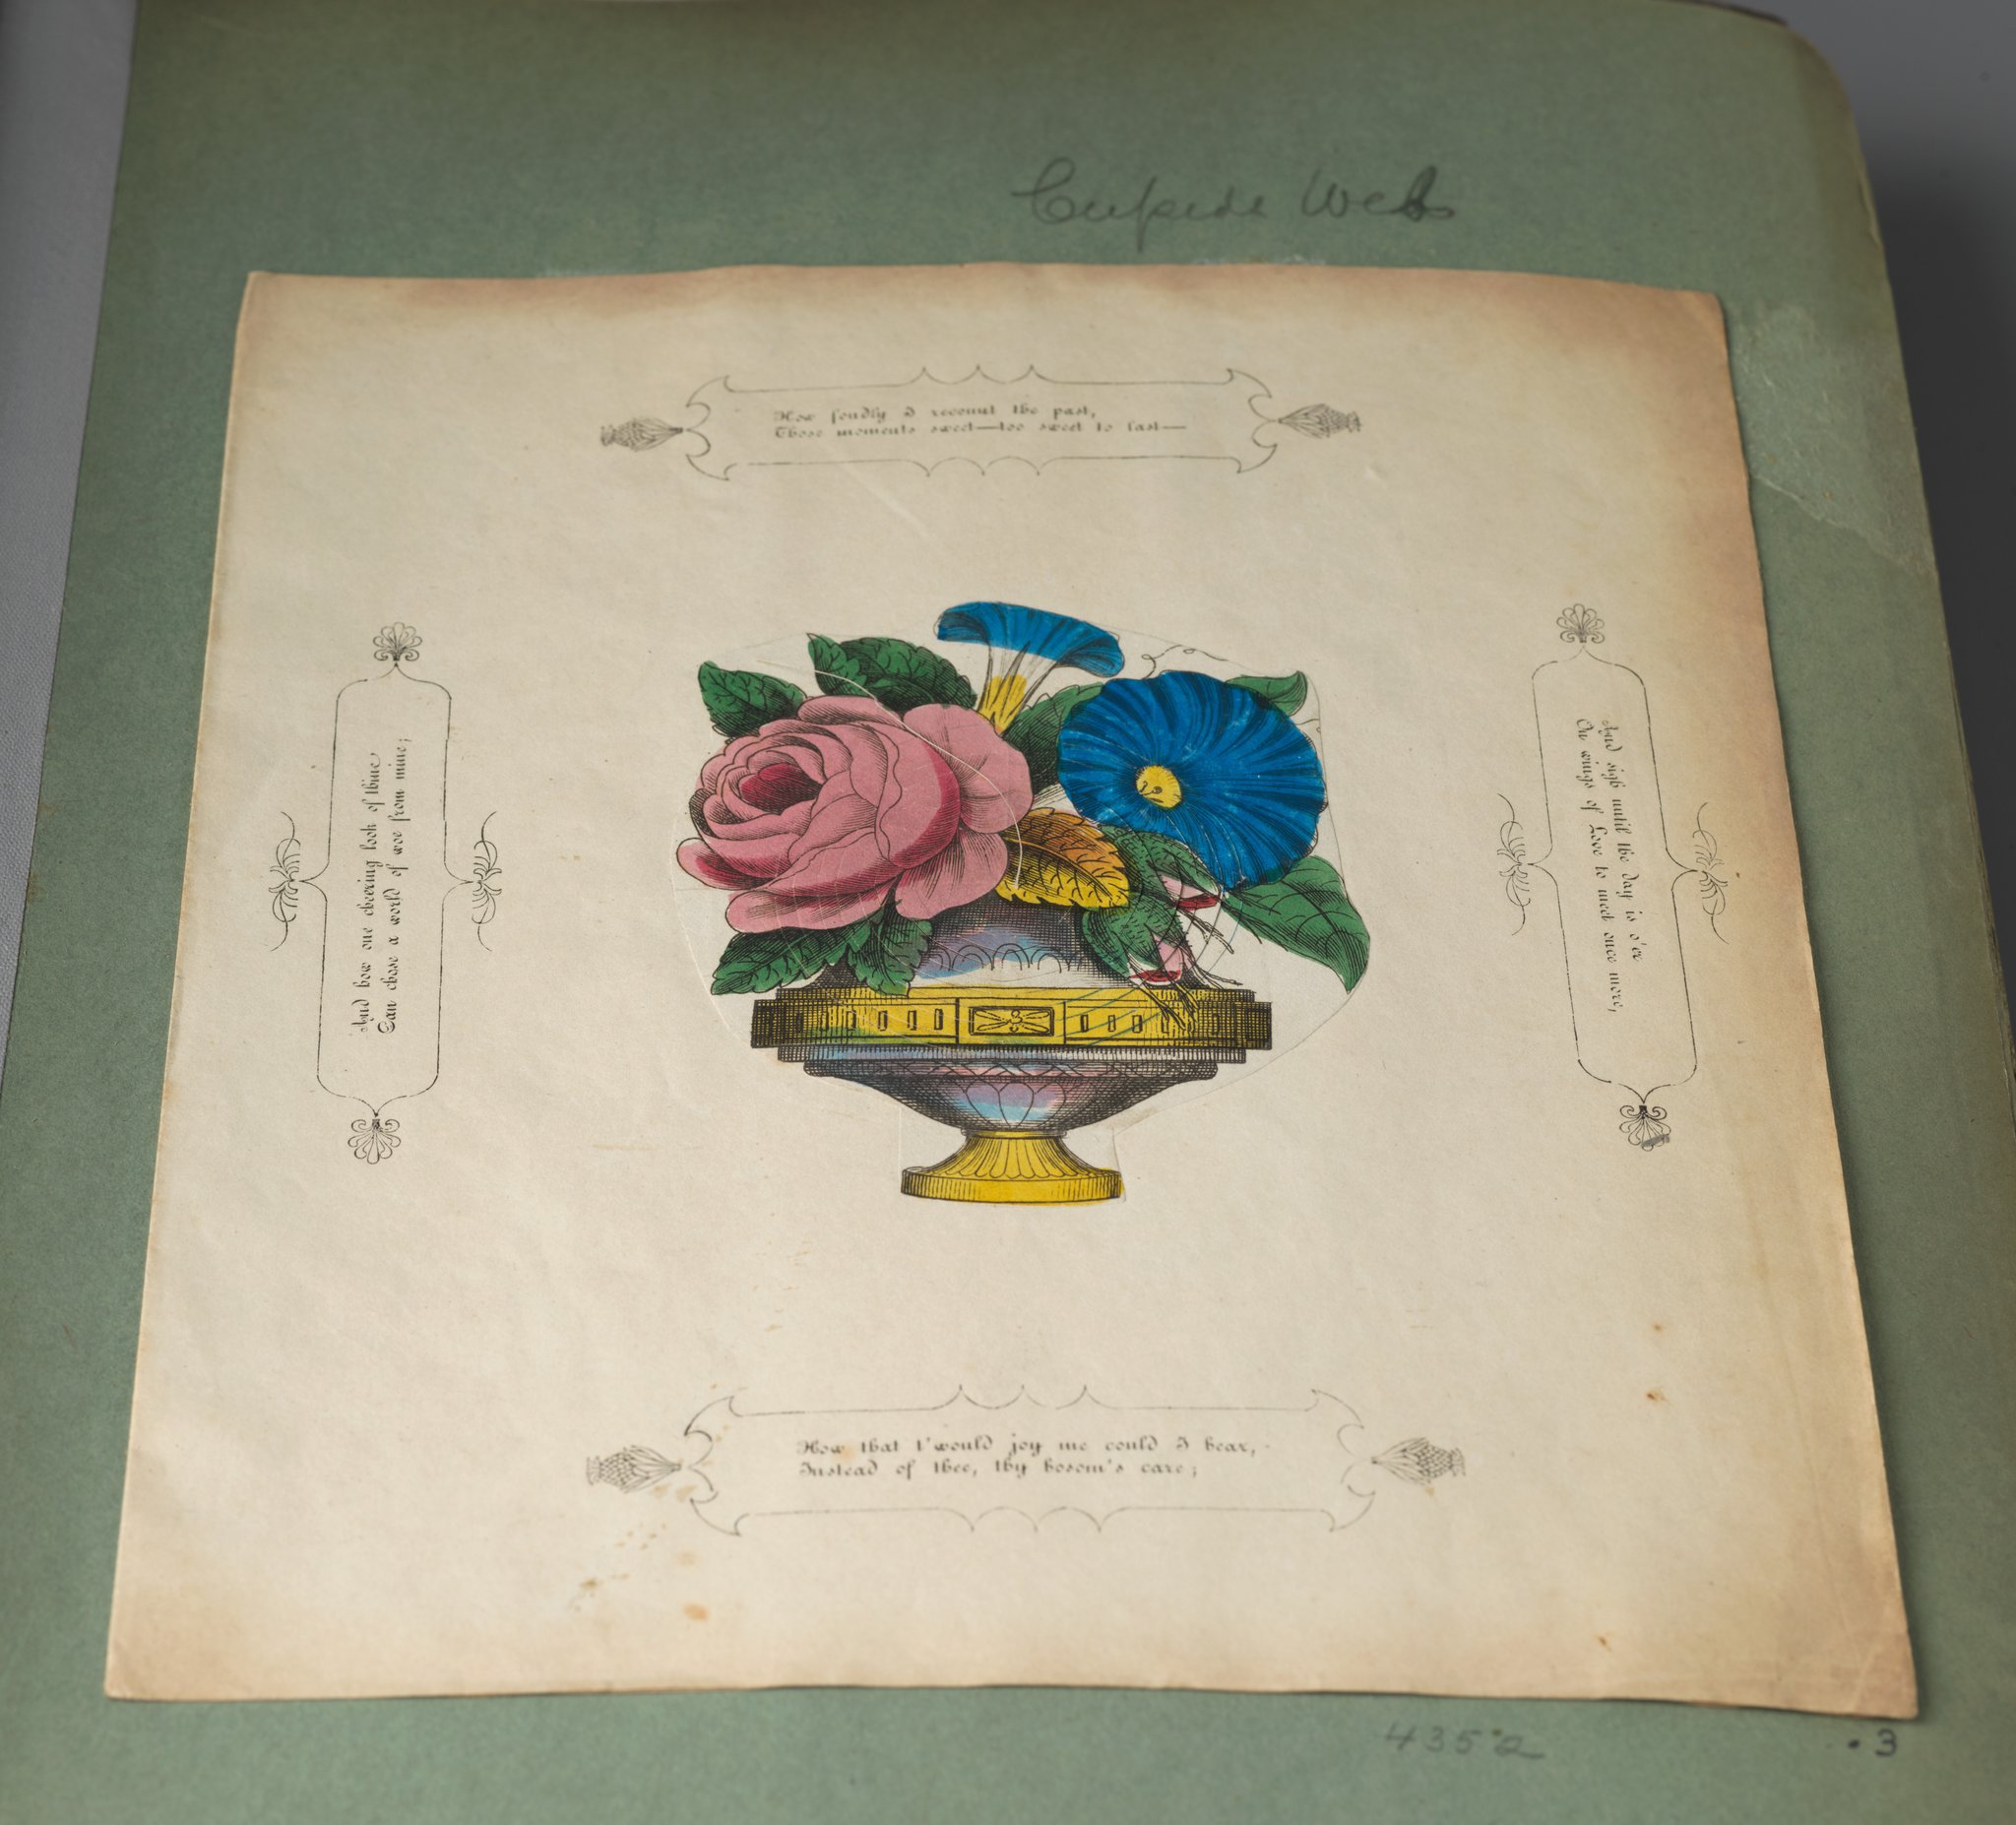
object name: valentine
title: Cobweb Valentine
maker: anonymous, british, 19th century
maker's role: artist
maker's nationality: british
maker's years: 1800-1900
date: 1860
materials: graphite, watercolor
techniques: lithograph